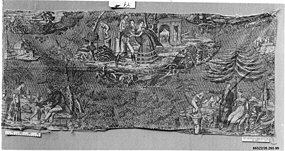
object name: furnishing textile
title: Pictorial print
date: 1801-1900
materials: cotton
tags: men,women,trees